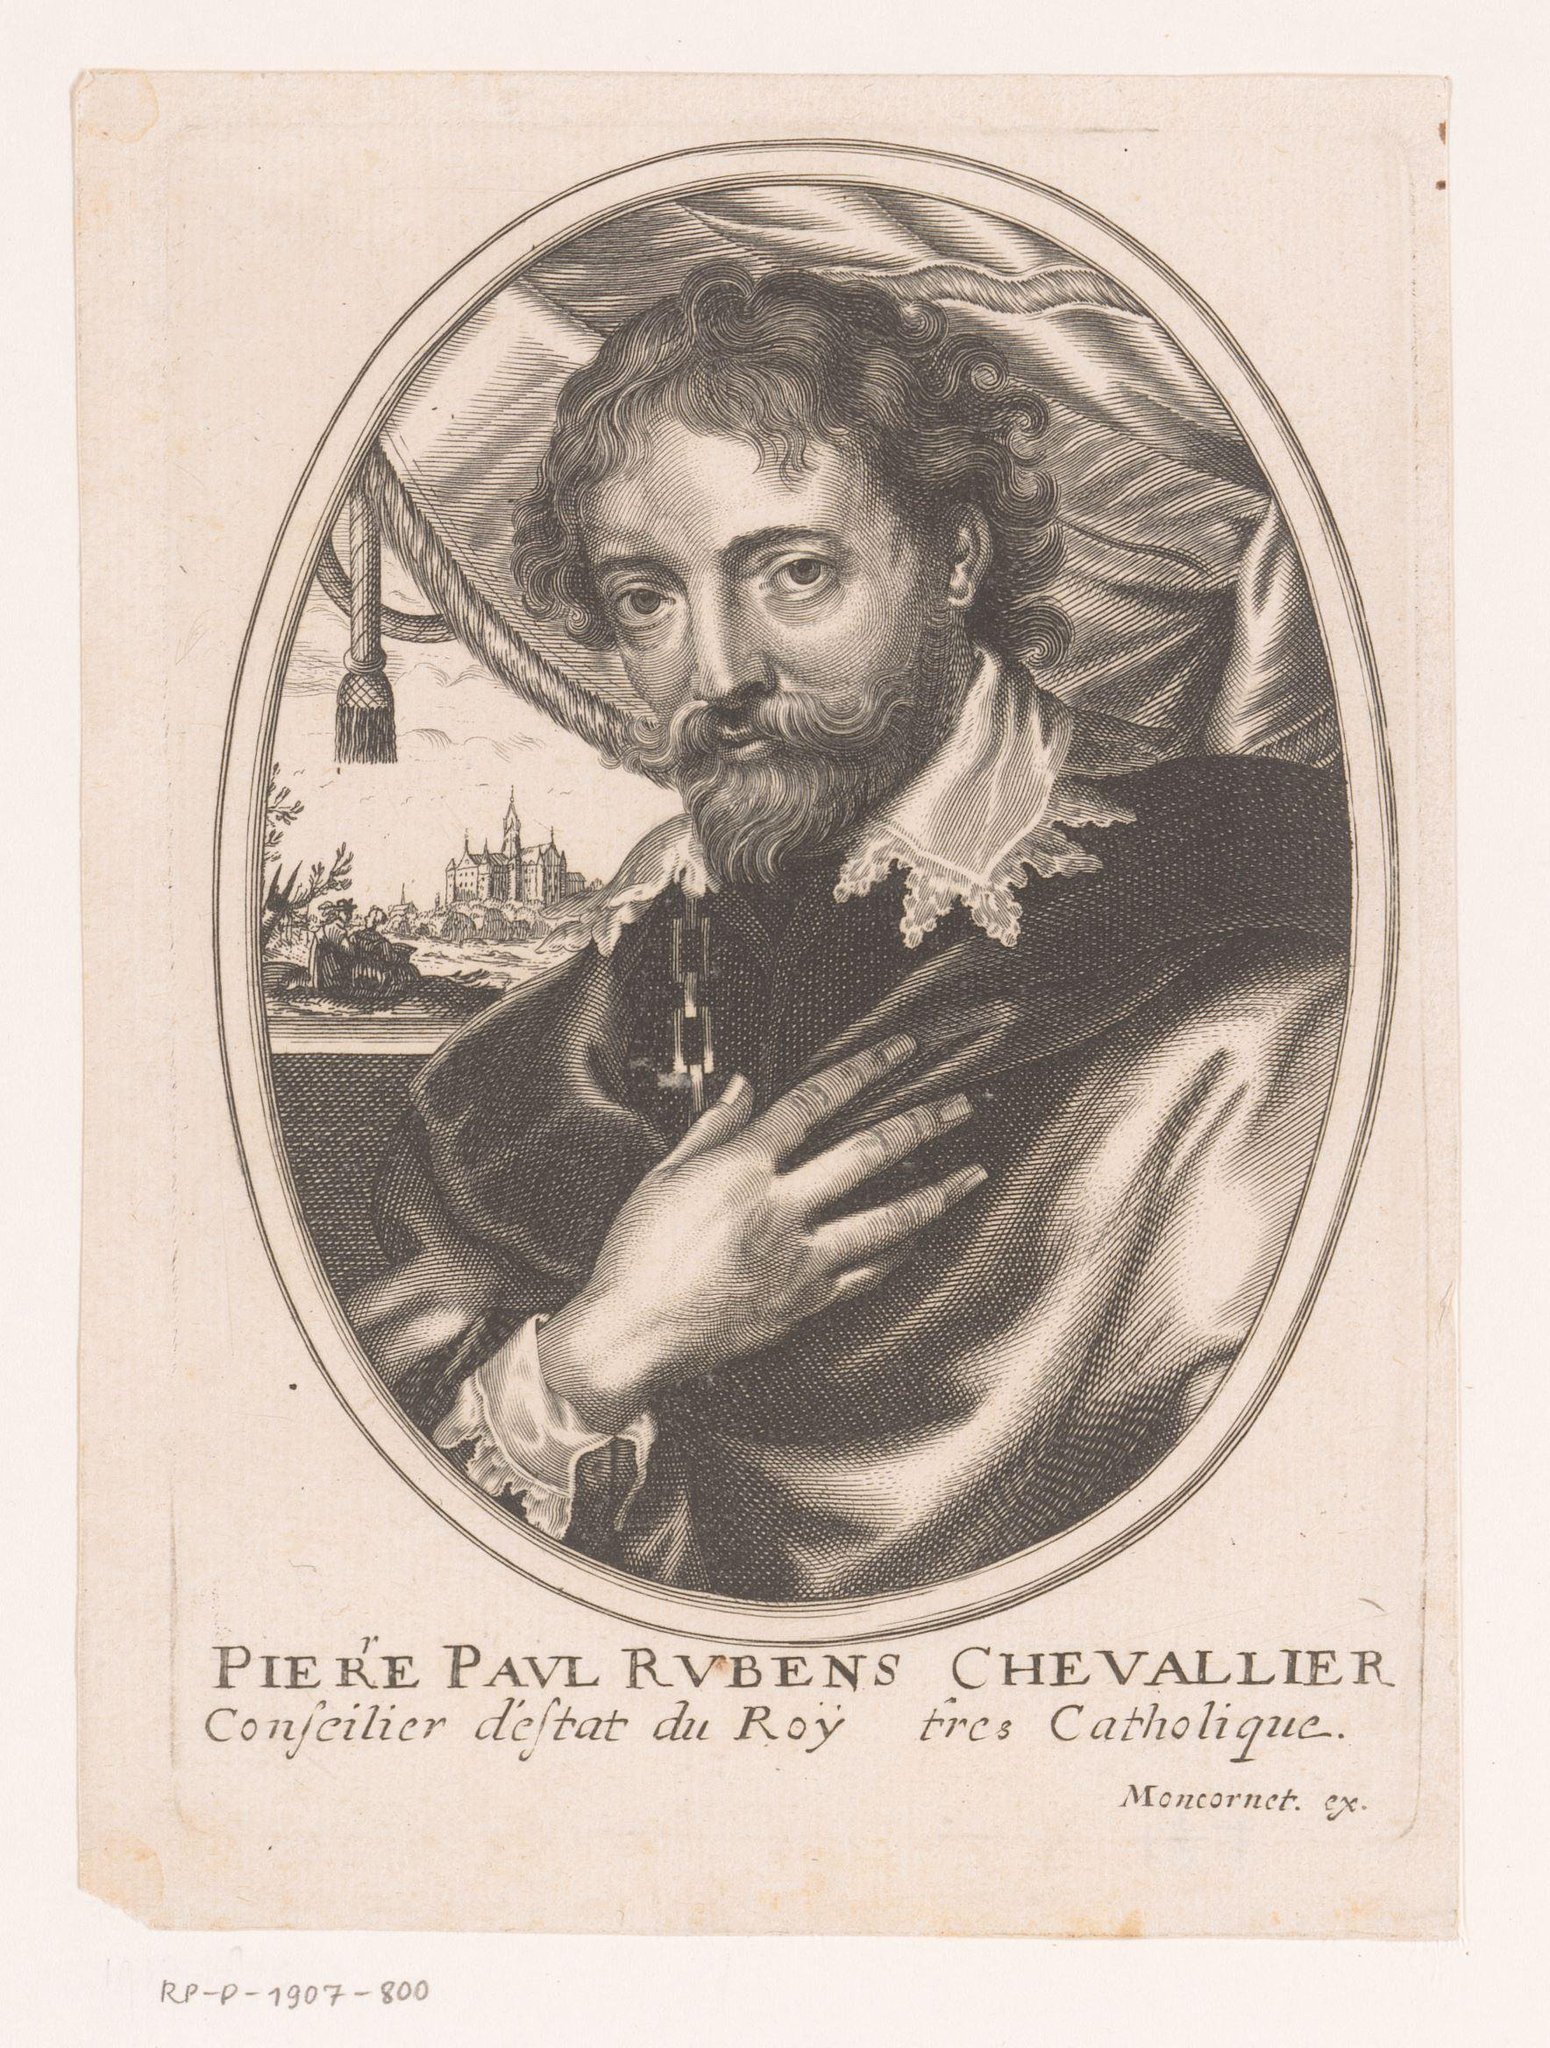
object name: print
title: Portret van Peter Paul Rubens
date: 1610-1668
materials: paper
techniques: engraving, etching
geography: paris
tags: antwerp, painter, print maker, draughtsman, peter paul rubens, historical persons, portrait, self-portrait of painter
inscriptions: collector's mark: Lugt 2228